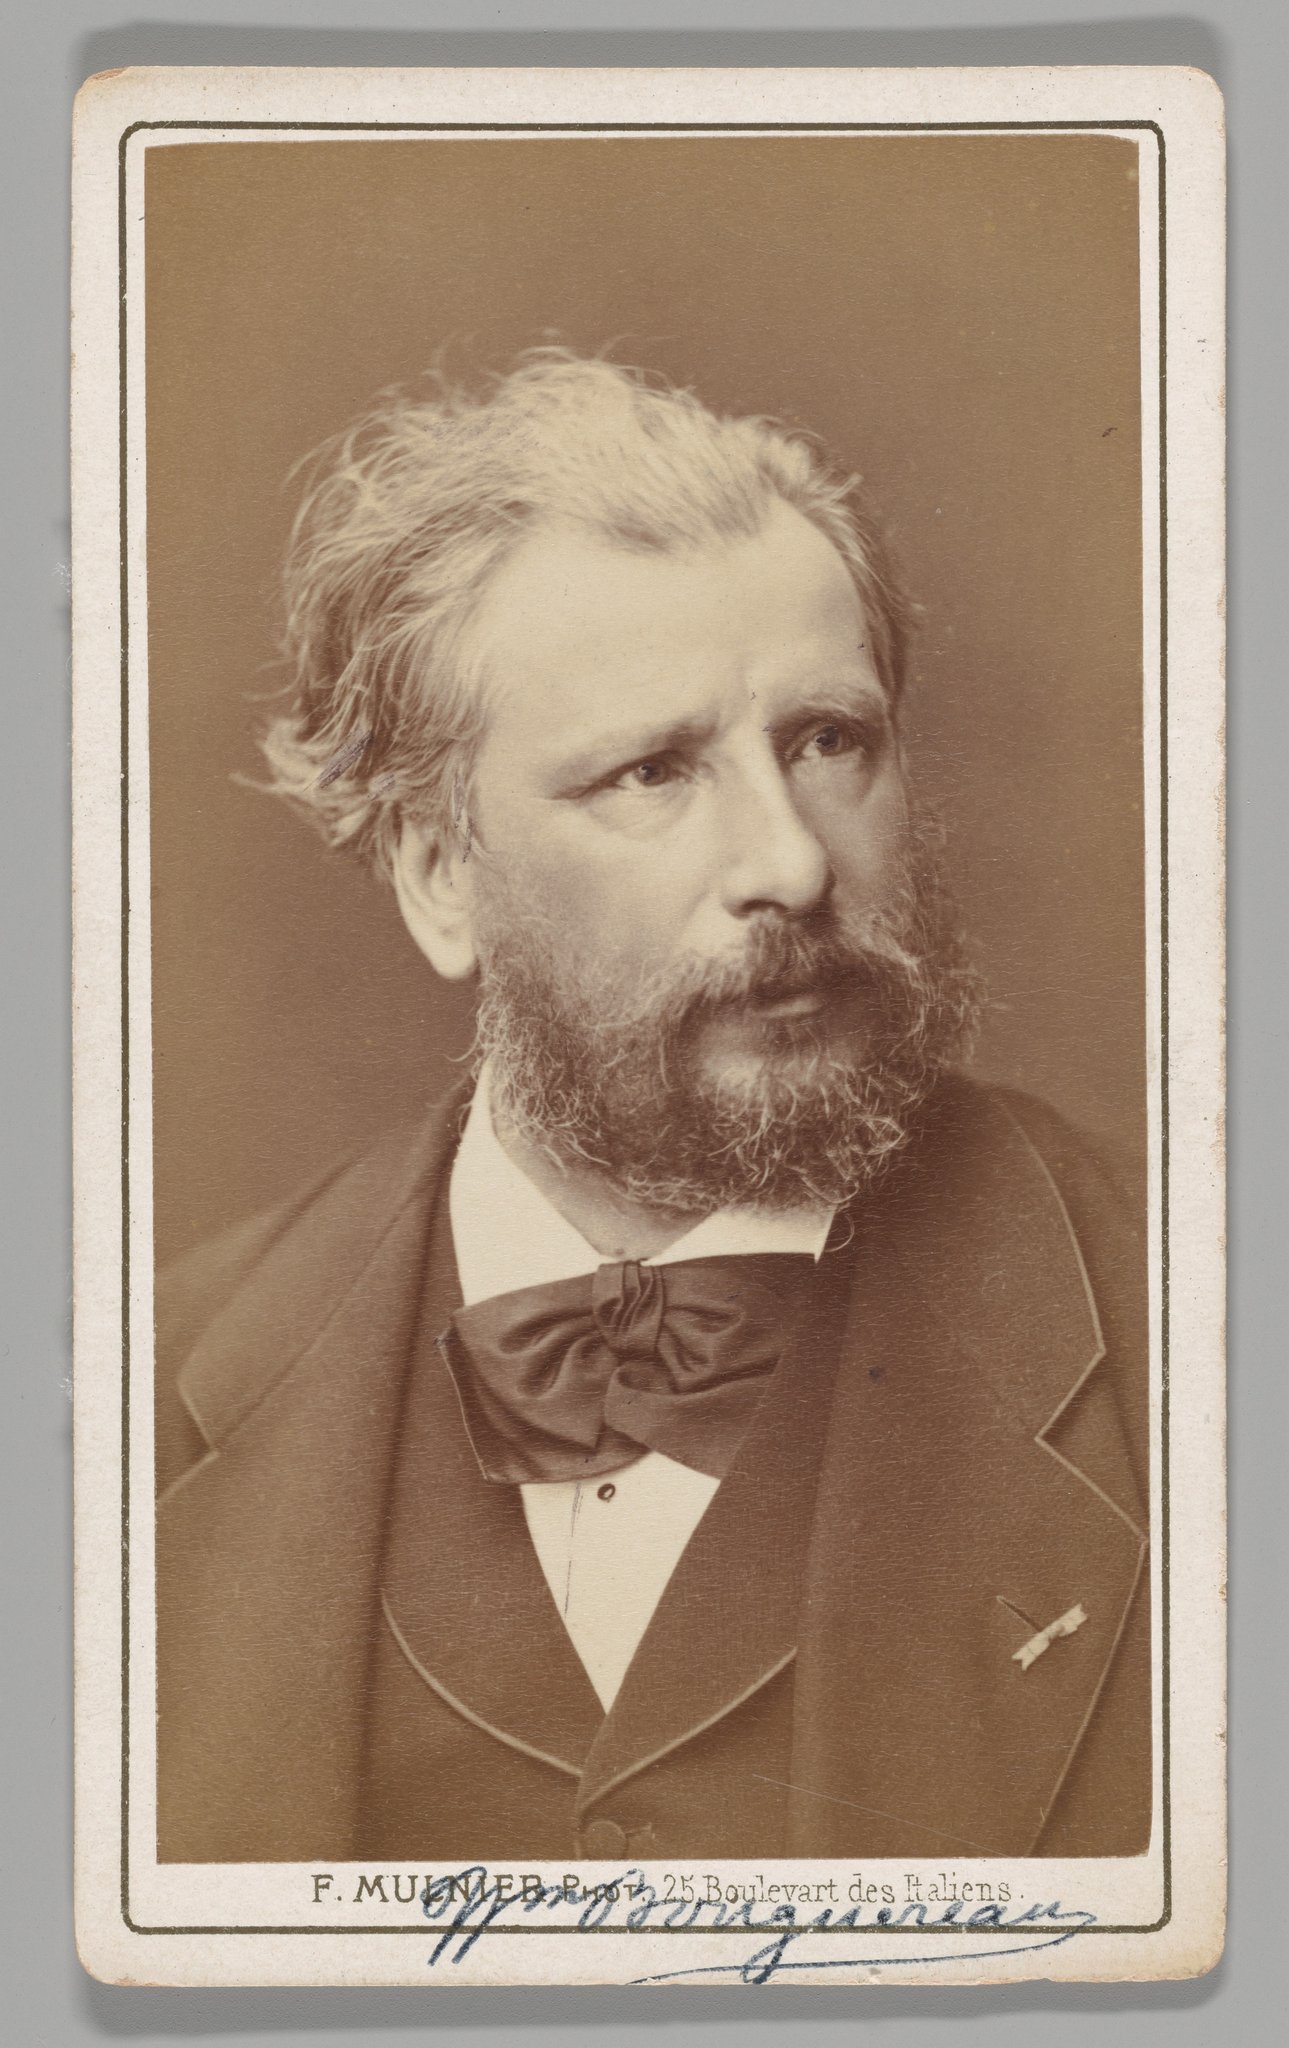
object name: carte de visite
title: [William-Adolphe Bouguereau]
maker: ferdinand mulnier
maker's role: artist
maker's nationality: french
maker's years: 1850-1875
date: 1857-1871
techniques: albumen silver print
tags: men,portraits